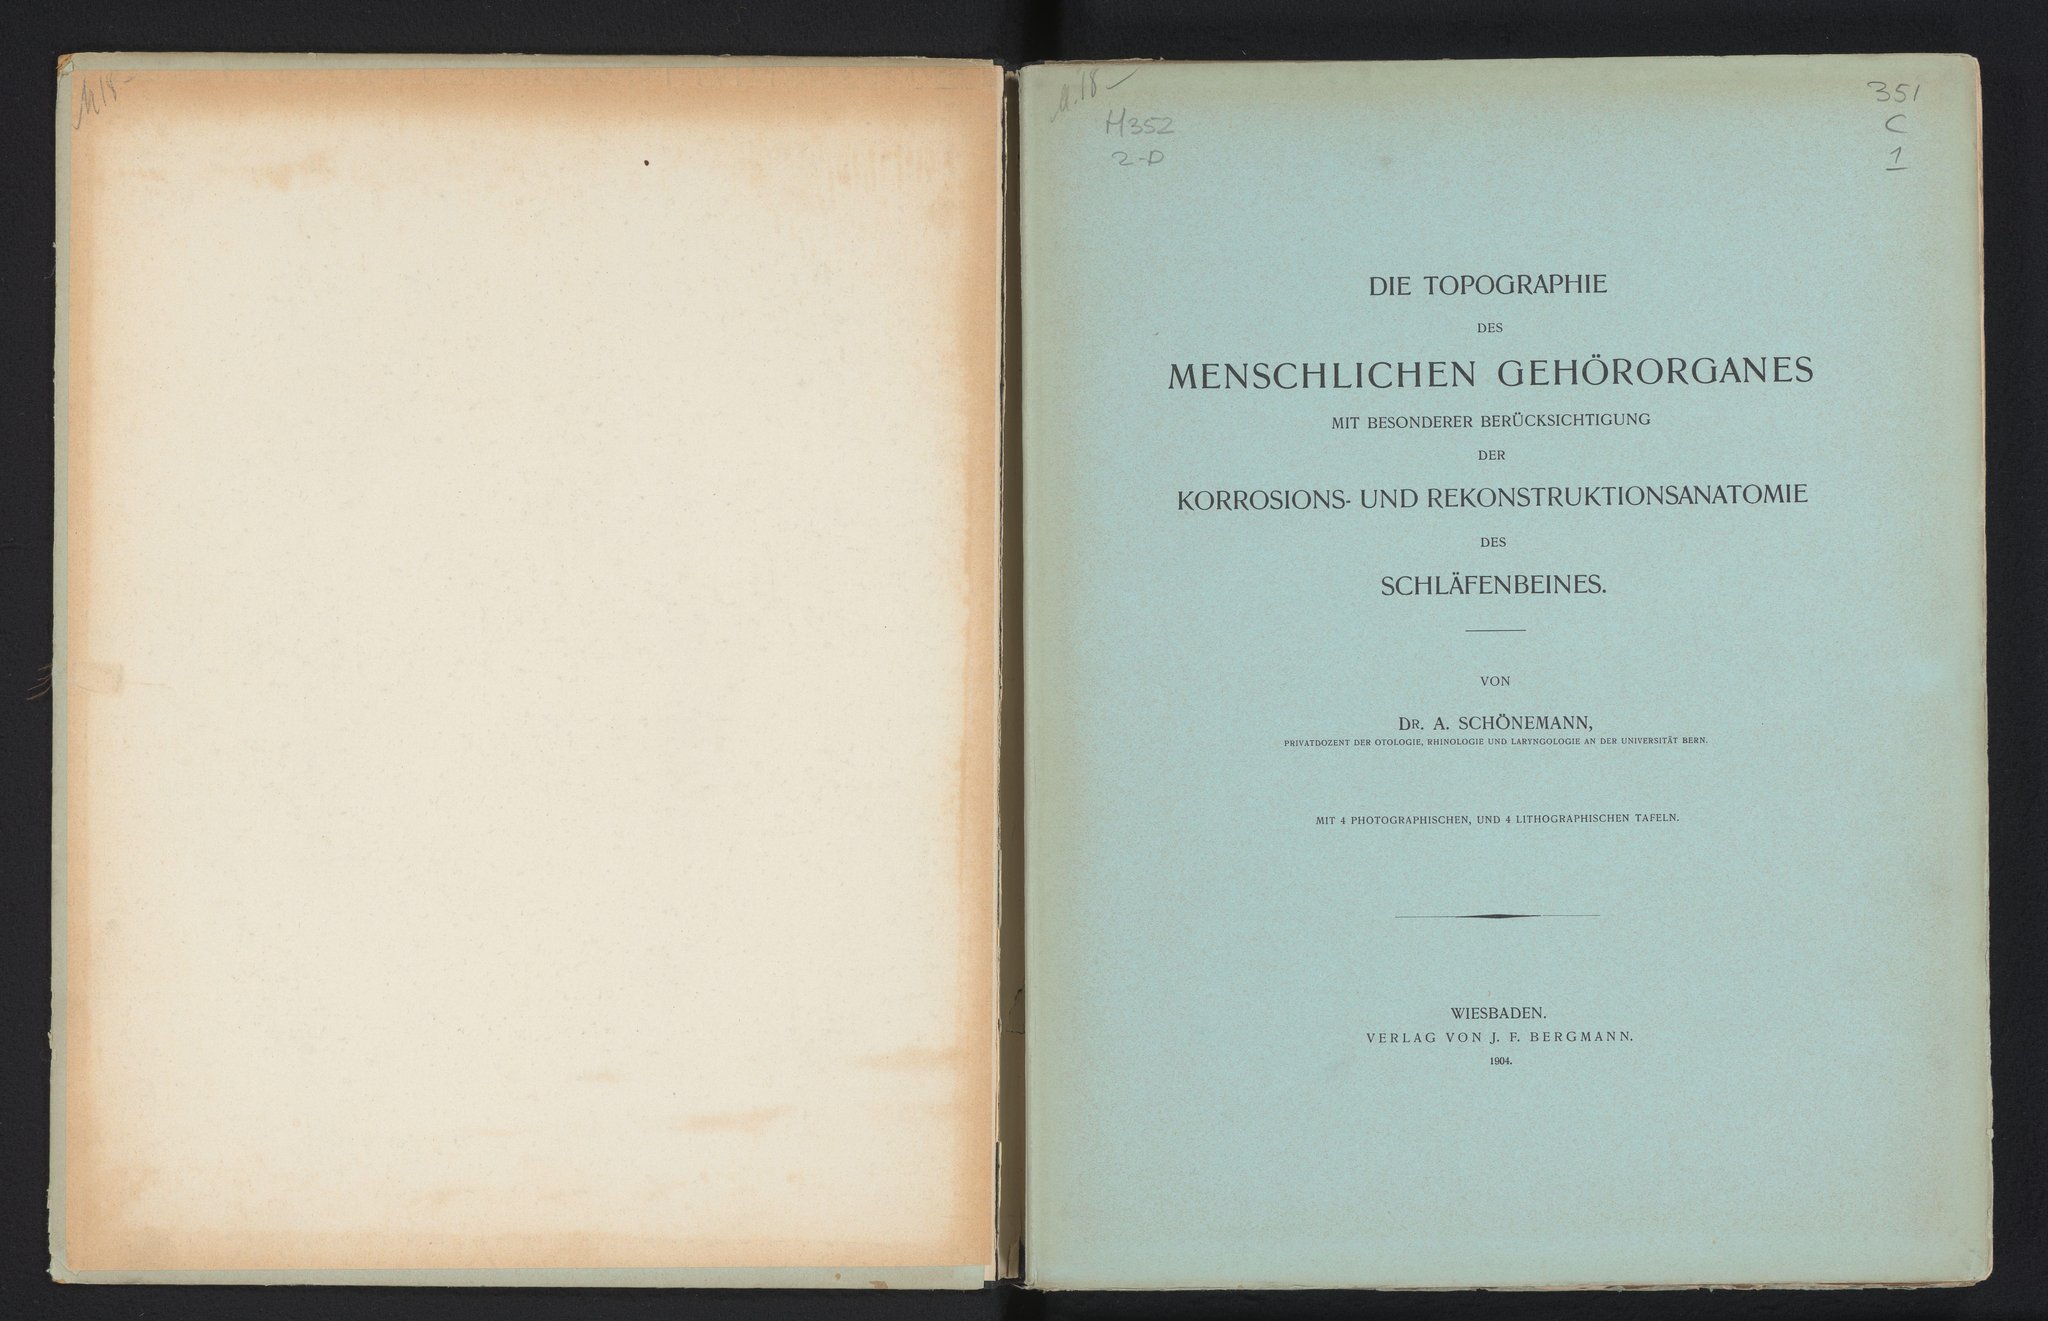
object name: book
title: Die Topographie des menschlichen Gehörorganes mit besonderer Berücksichtigung der Korrosions- und Rekonstruktionsanatomie des Schläfenbeines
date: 1904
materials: paper, cardboard, textile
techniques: gelatin silver print, letterpress printing, lithograph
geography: würzburg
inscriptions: inscription: ‘M.18-’, number: ‘1325’, inscription: ‘M.18_’